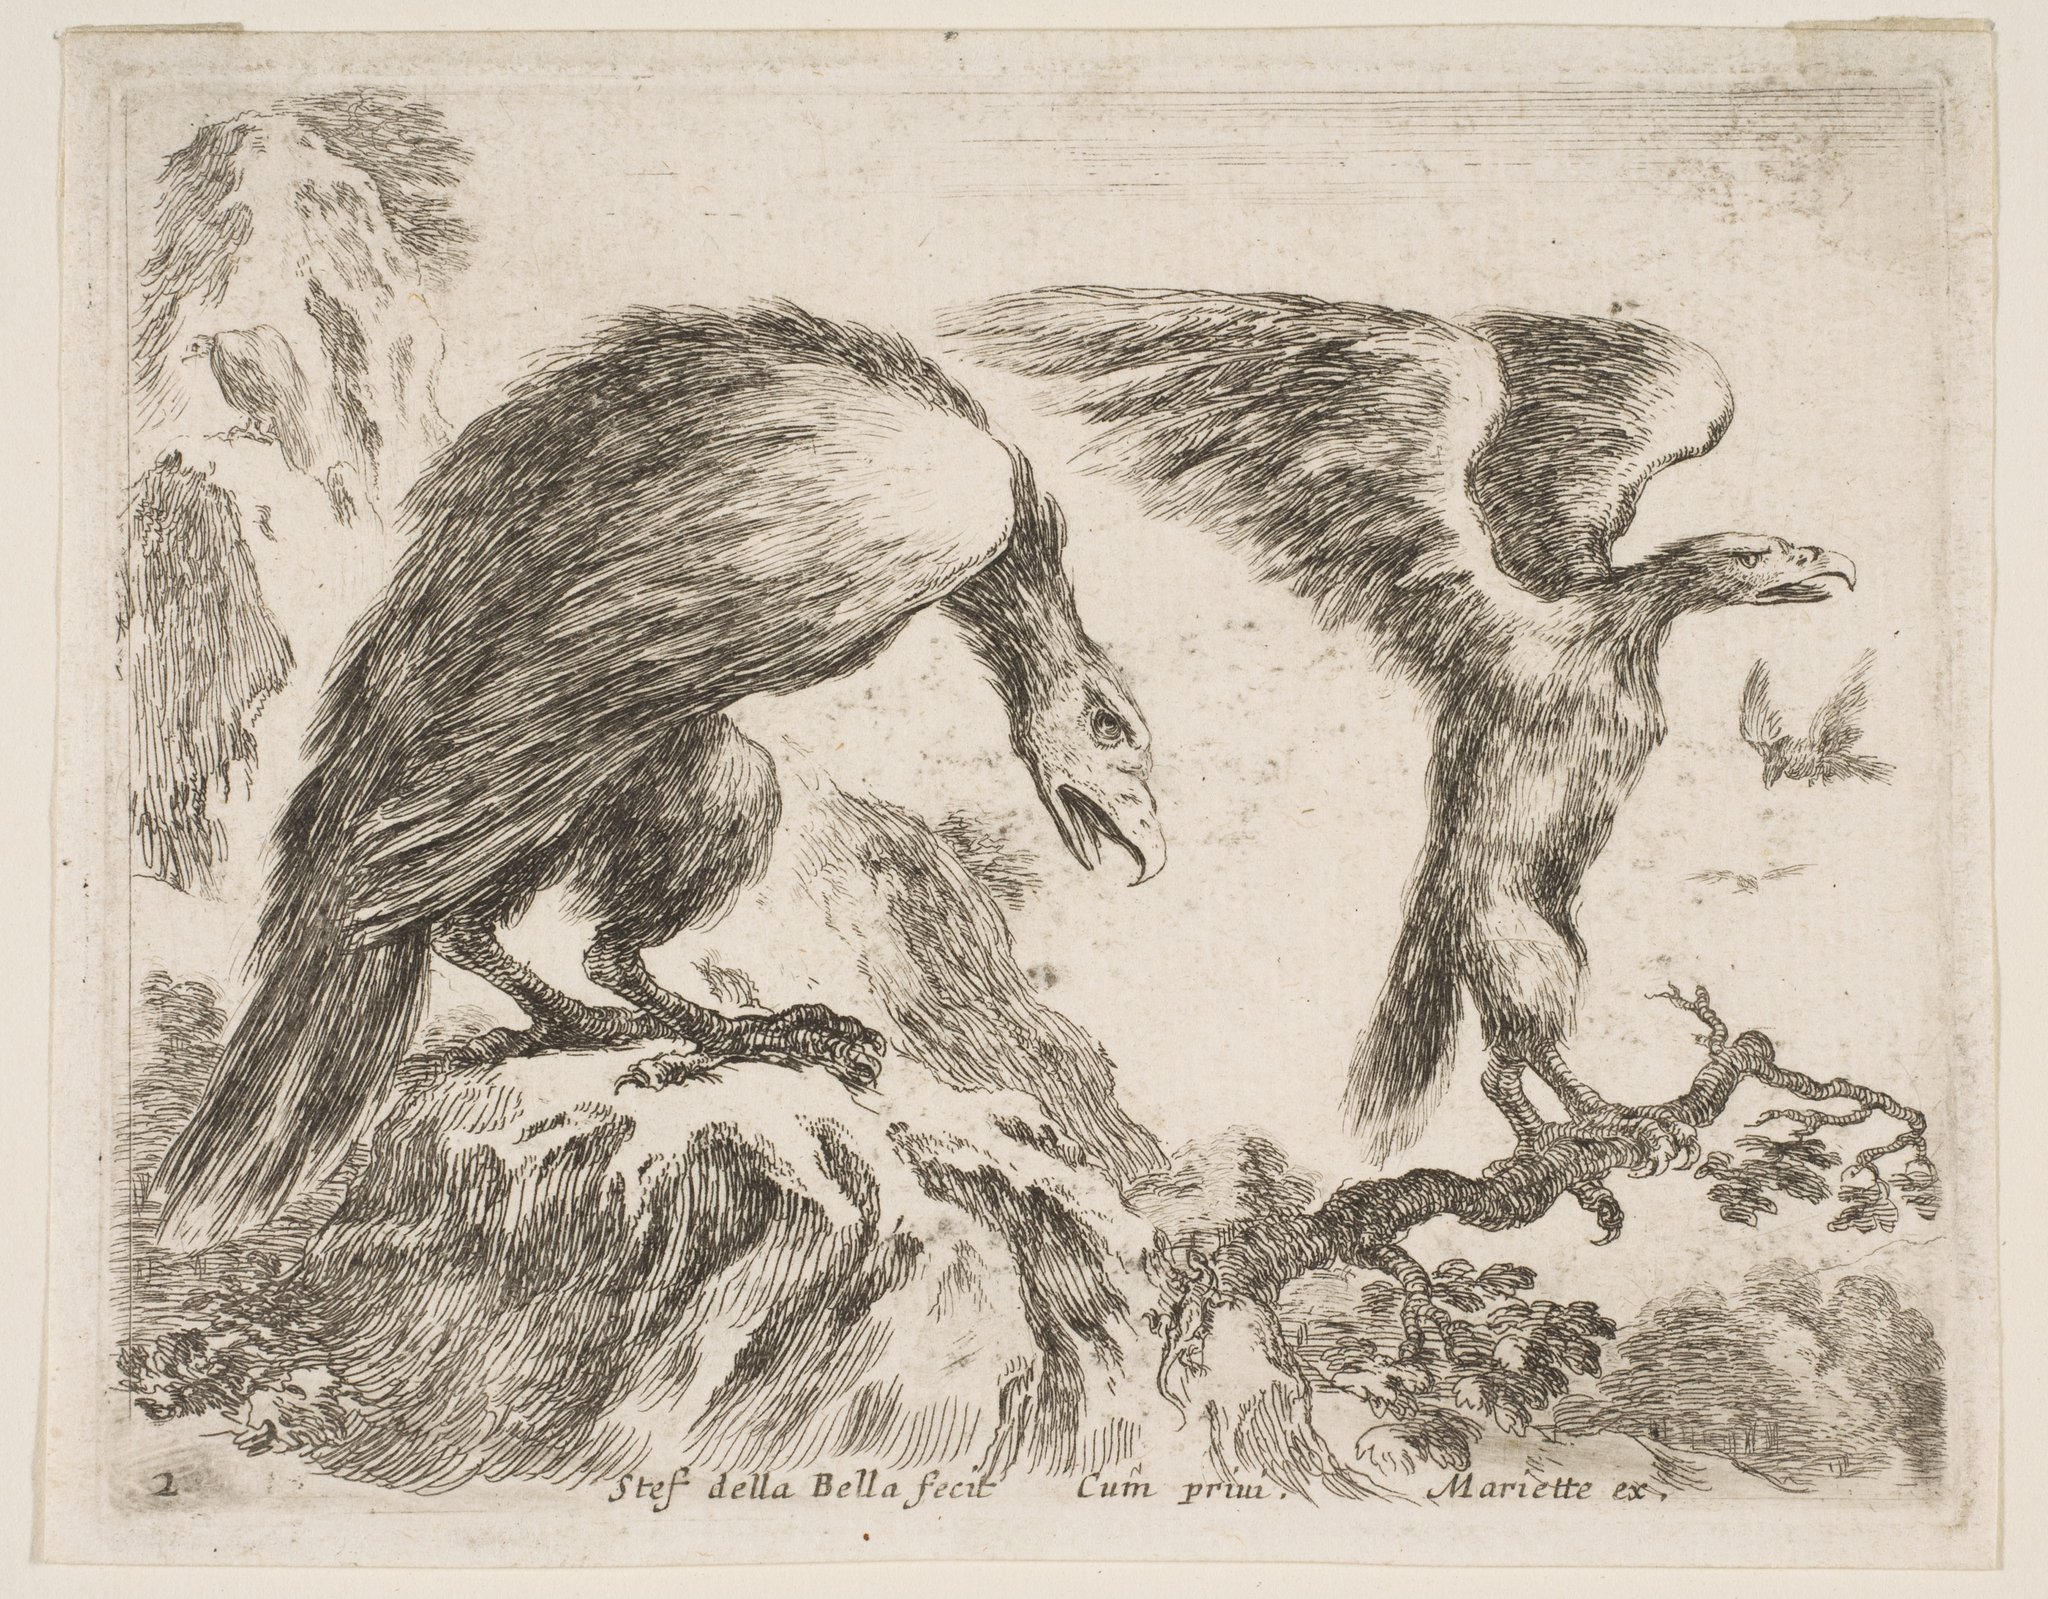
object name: print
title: Eagle and eaglet, plate 2 from "Various Animals" (Diversi Animali)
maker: stefano della bella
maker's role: artist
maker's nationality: italian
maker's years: 1610-1664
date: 1641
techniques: etching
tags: eagles